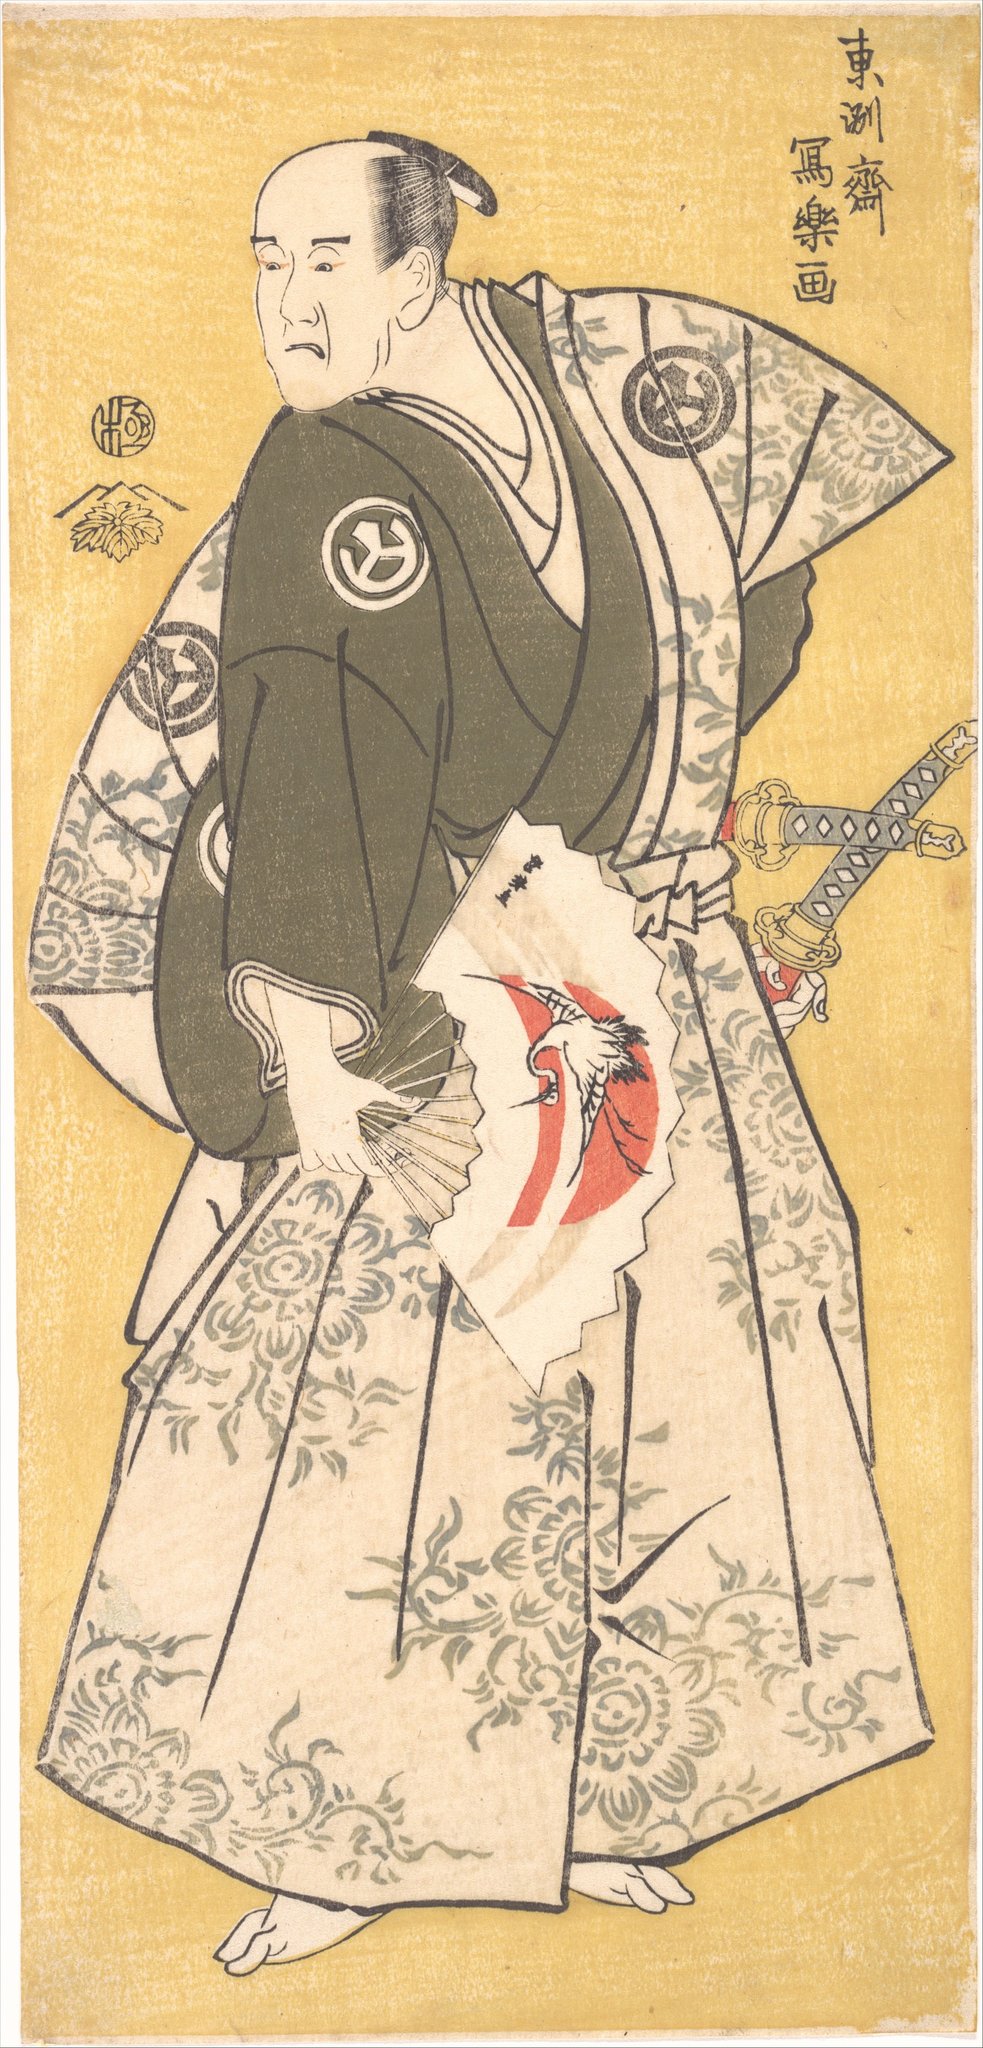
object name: print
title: Yamashina Shirojuro in the Role of Nagoya Sanzaemon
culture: japanese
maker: tōshūsai sharaku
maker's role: artist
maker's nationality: japanese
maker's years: 1794-1795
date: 1794-1795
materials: ink, paper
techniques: woodblock print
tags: fans,men,actors